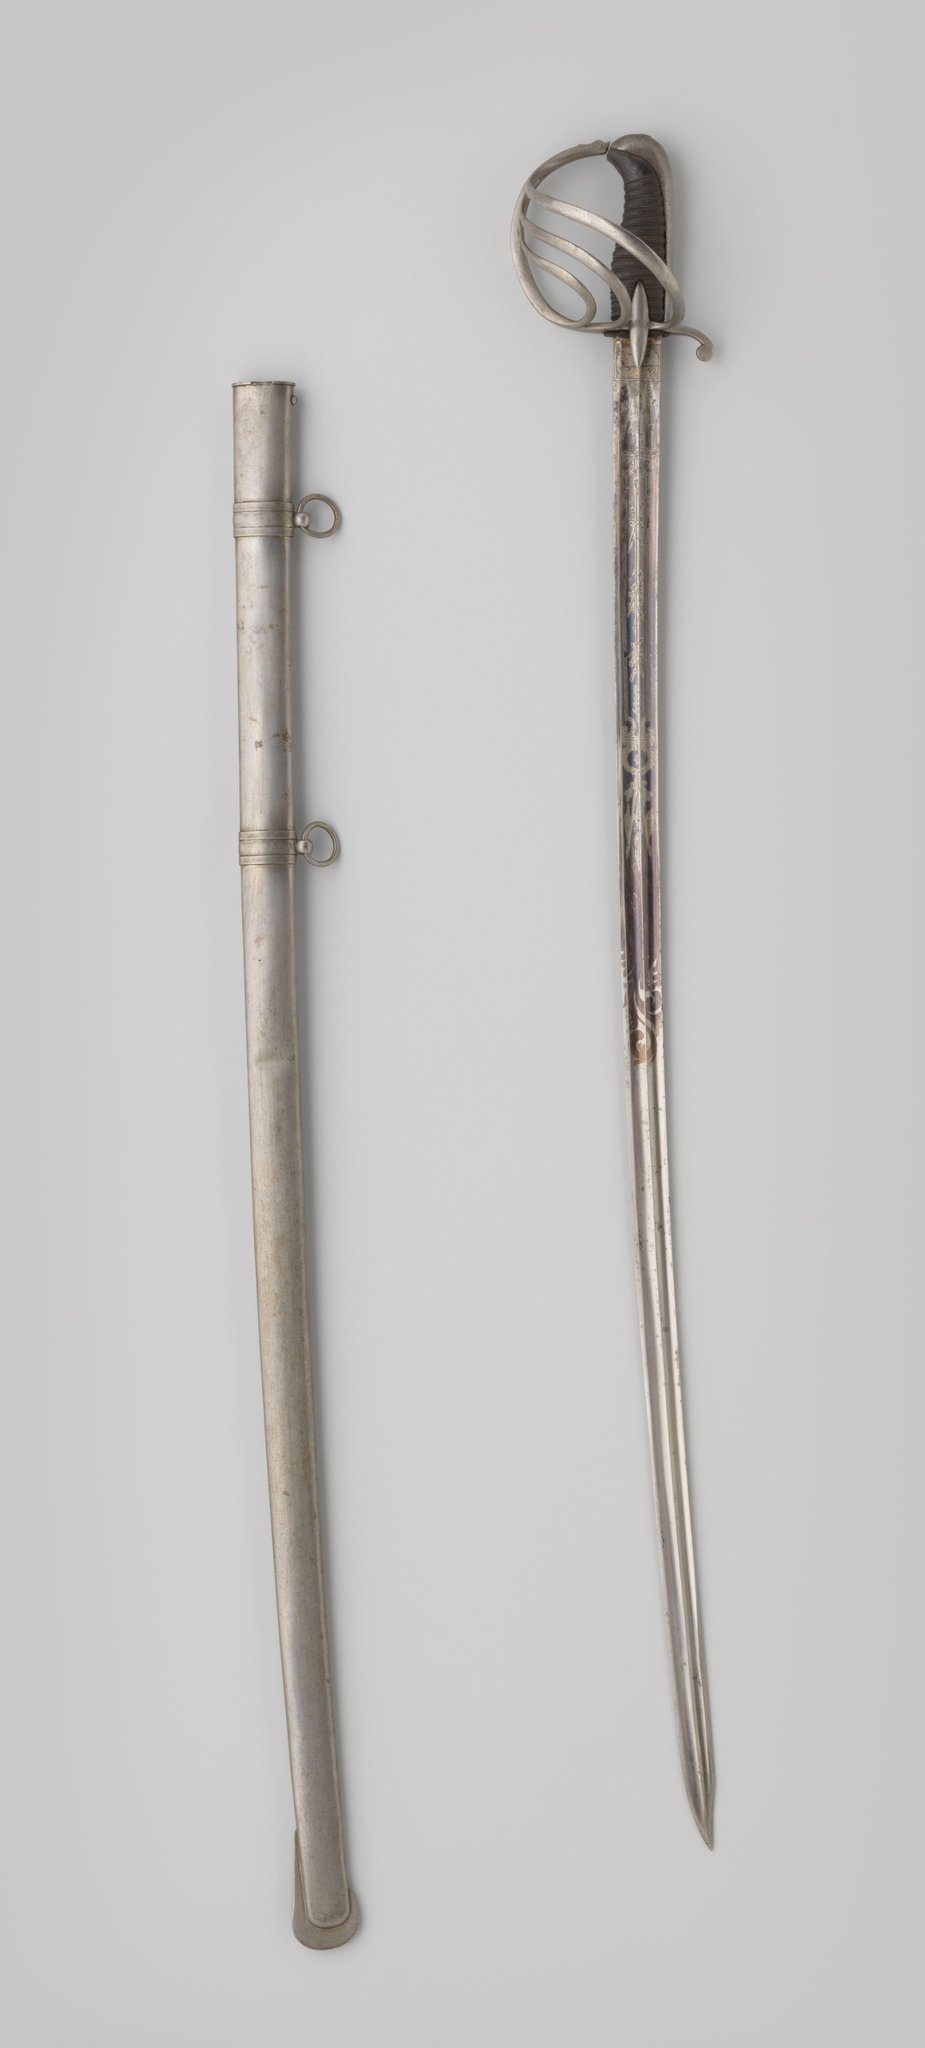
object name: sabre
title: Officierssabel lichte cavalerie, model nr. 2 van J.A. de Vos van Steenwijk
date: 1813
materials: iron, leather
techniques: engraving, gilding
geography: solingen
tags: netherlands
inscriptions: : ‘Schimmelbusch & Zoon Solingen’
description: Officierssabel lichte cavalerie model nr. 2. De kling is recht en gemerkt: Schimmelbusch & Zoon Solingen. Geweest van J.A. de Vos van Steenwijk.